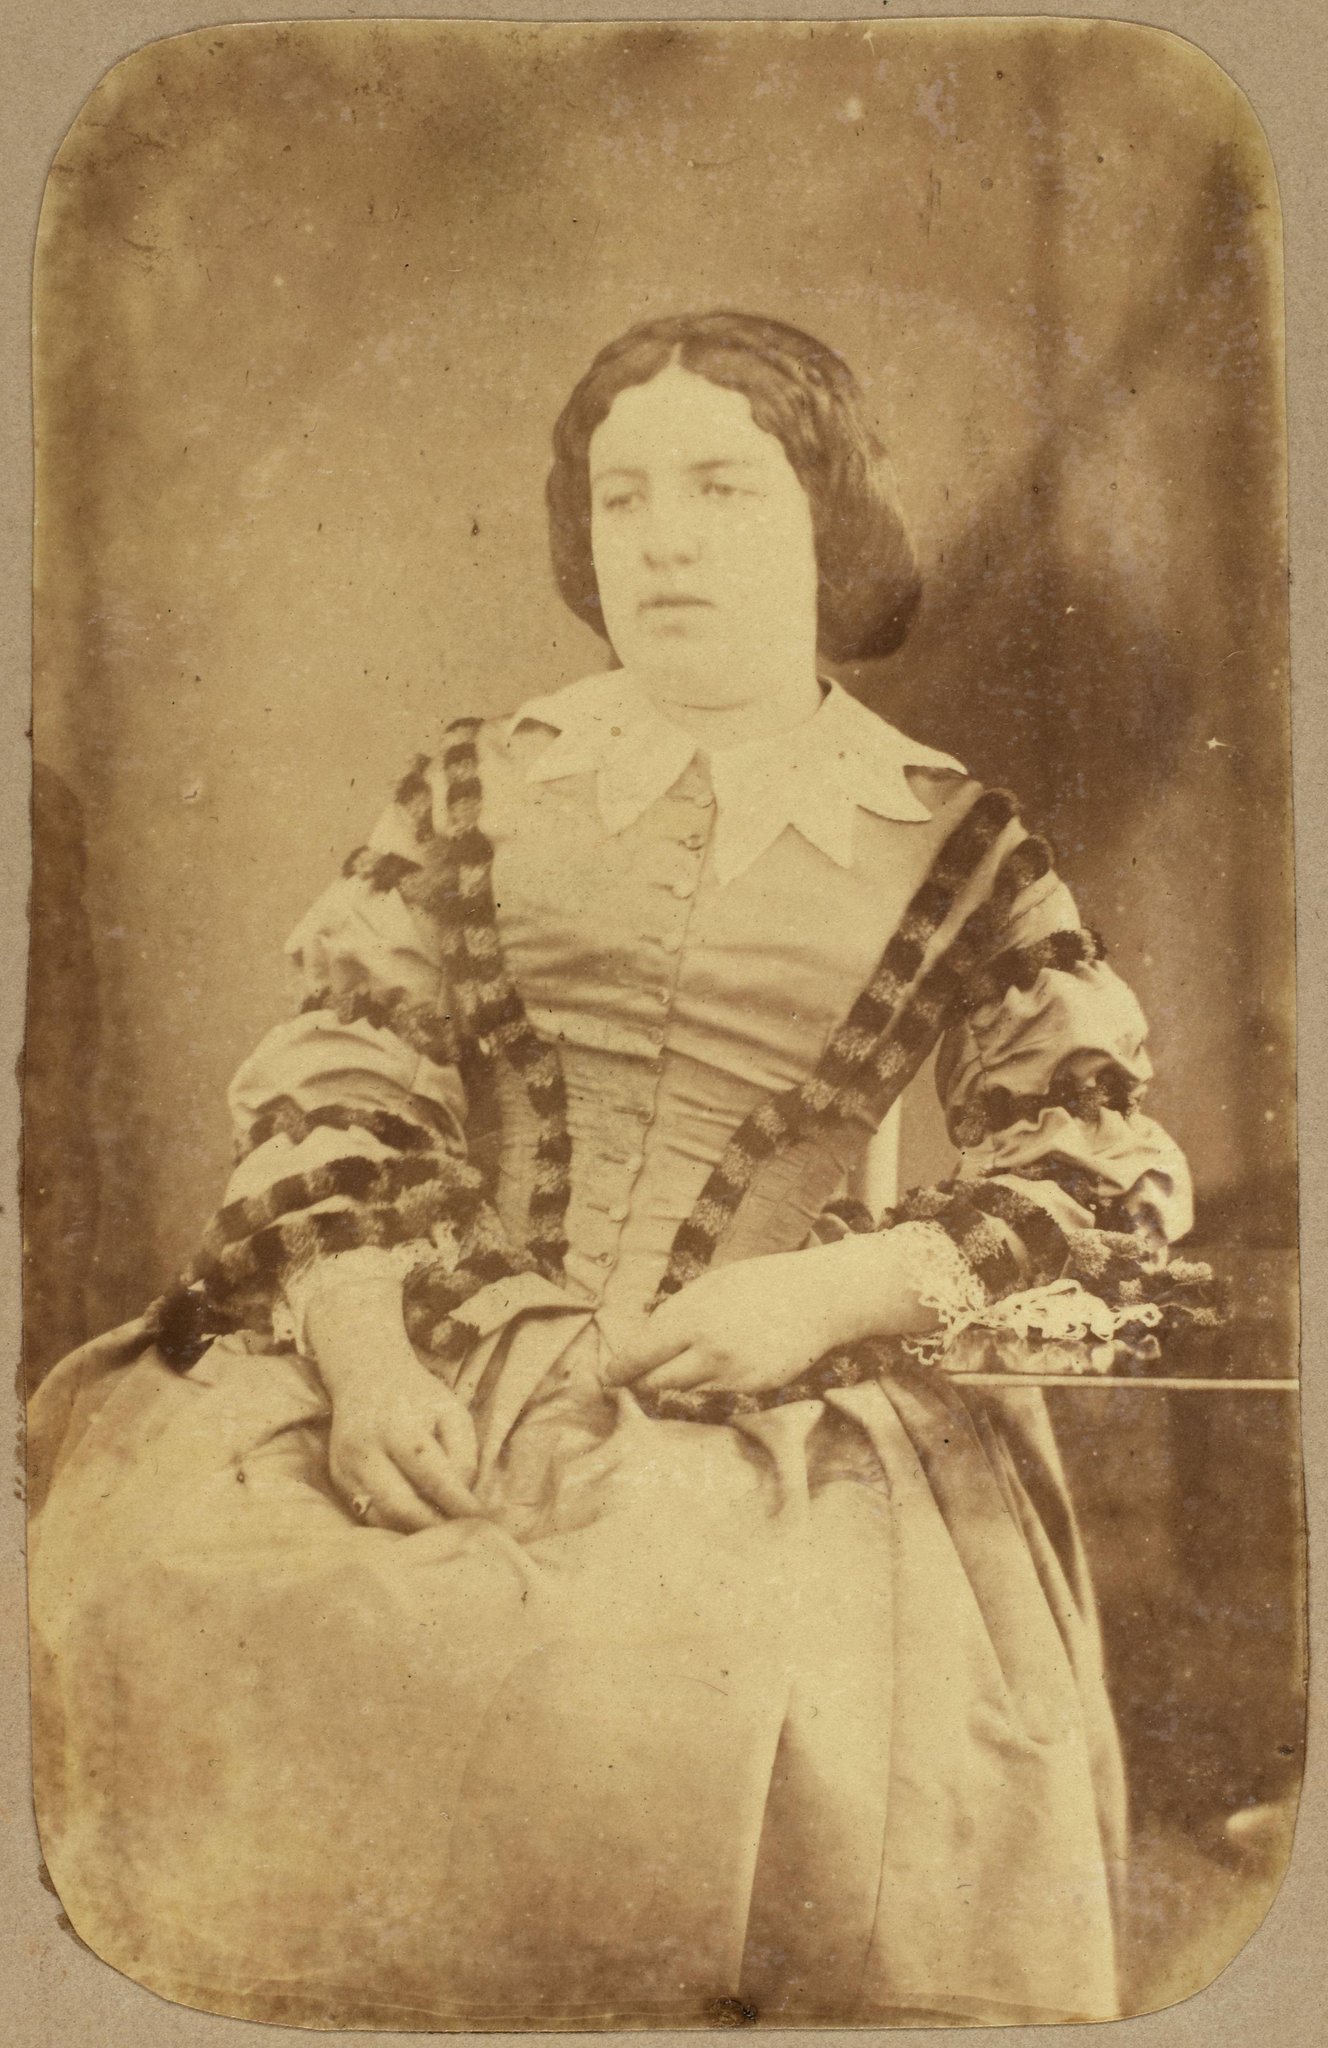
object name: photograph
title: Portret van Charlotte Asser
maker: eduard isaac asser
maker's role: amateurfotograaf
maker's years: 1809-1894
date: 1854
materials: cardboard, paper, photographic support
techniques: salted paper print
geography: amsterdam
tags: amsterdam, brussels, historical persons - bb - woman, netherlands